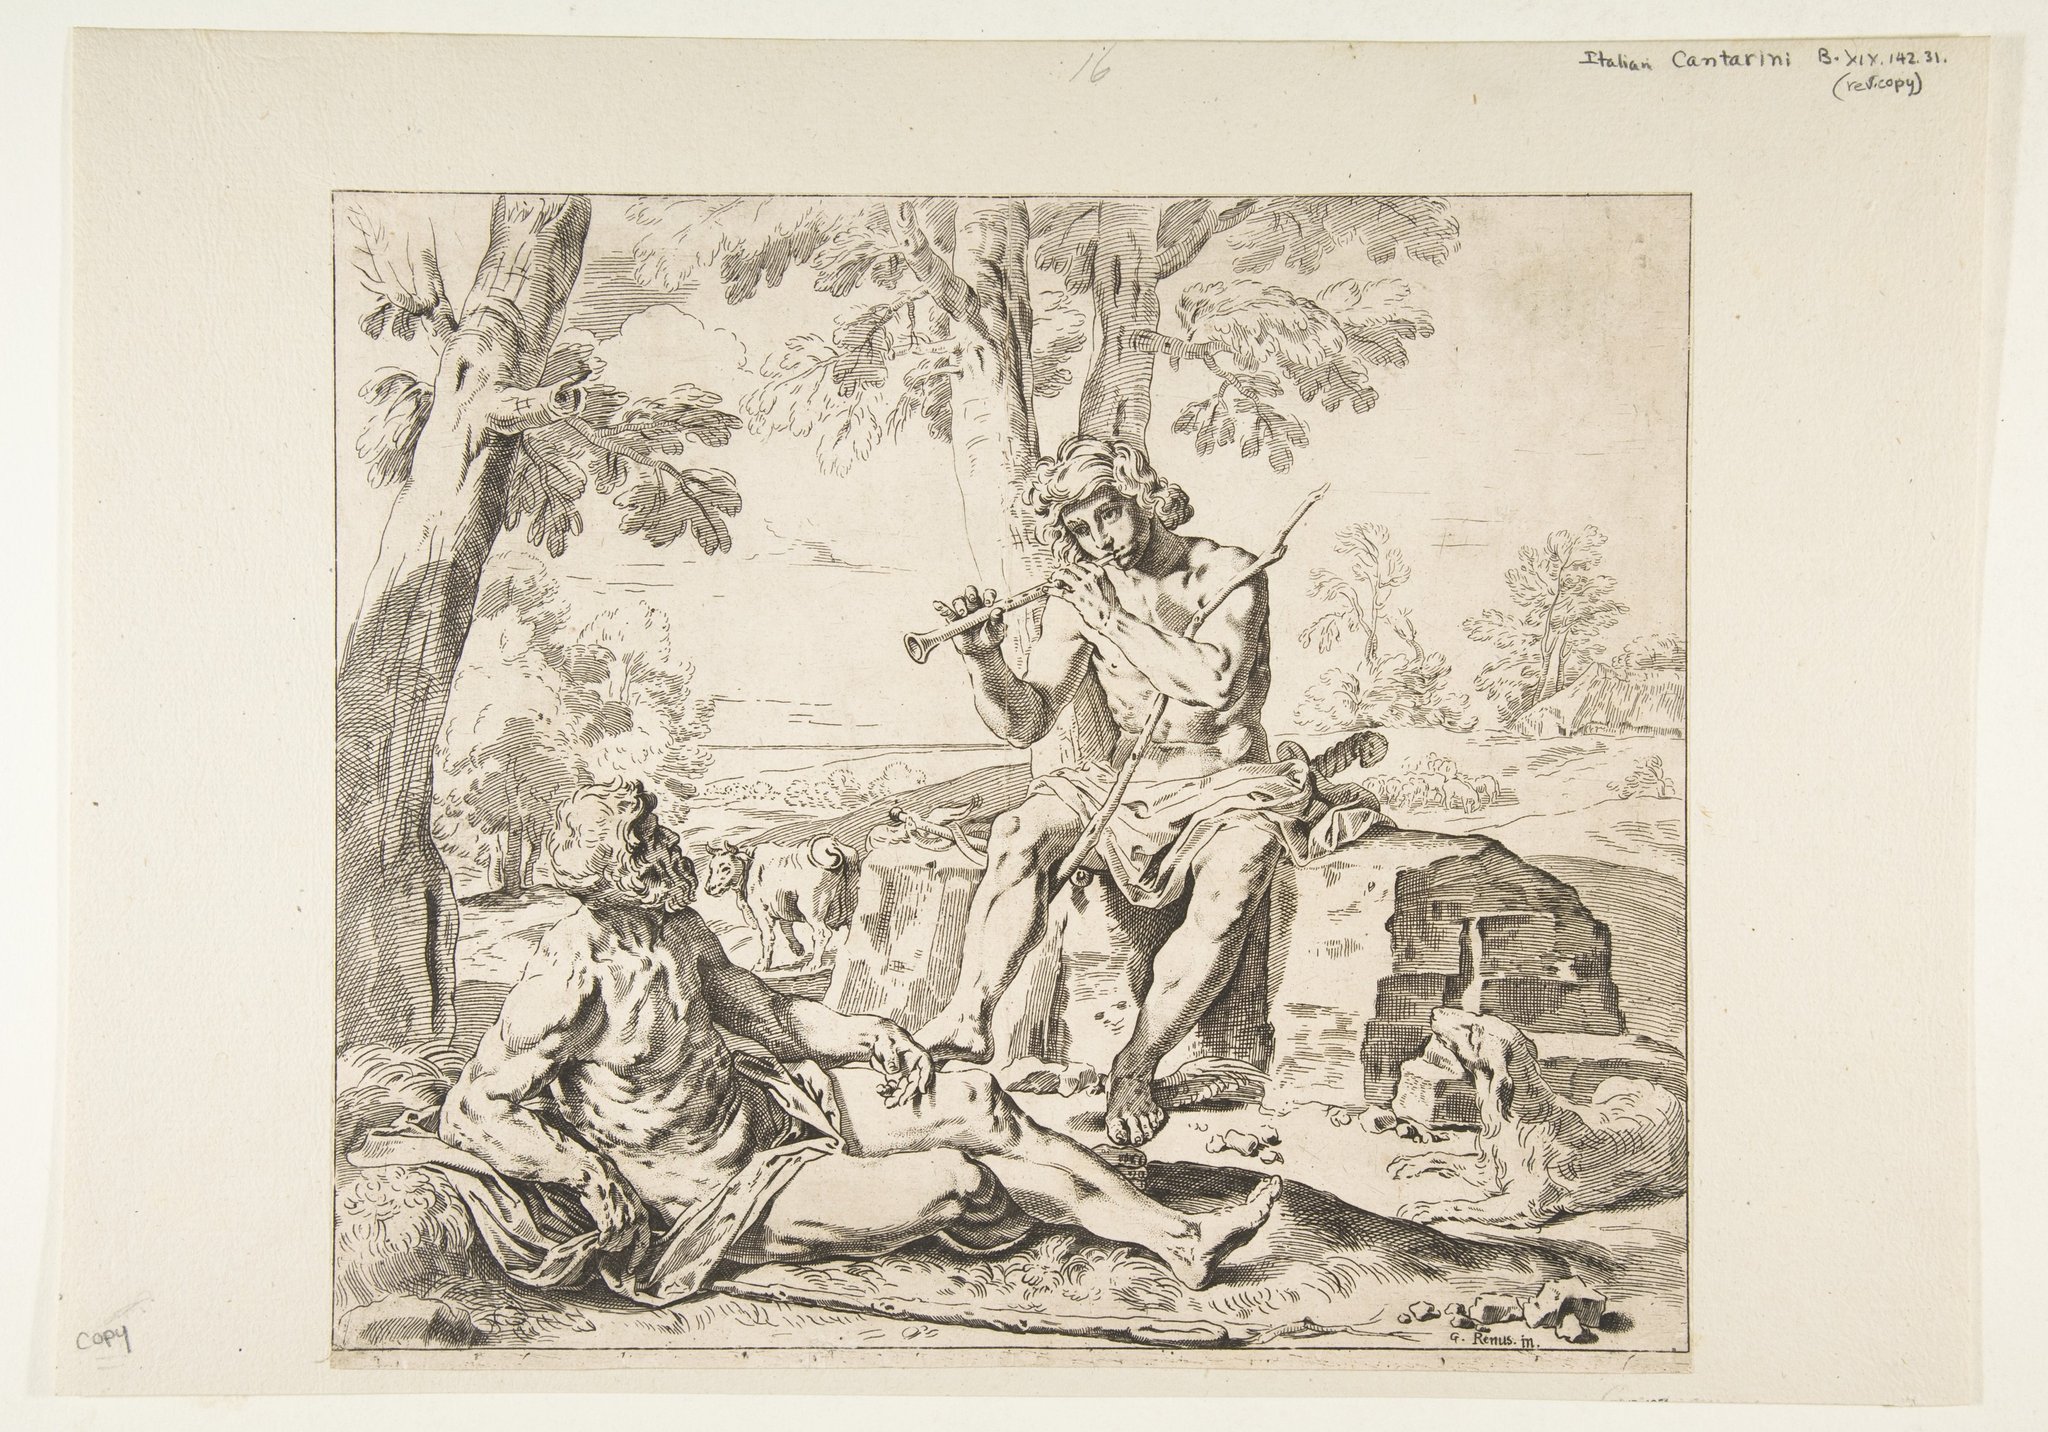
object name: print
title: Mercury and Argus, copy in reverse after Cantarini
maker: simone cantarini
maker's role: artist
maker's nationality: italian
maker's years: 1612-1648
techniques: etching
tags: musical instruments,men,mercury,dogs,trees